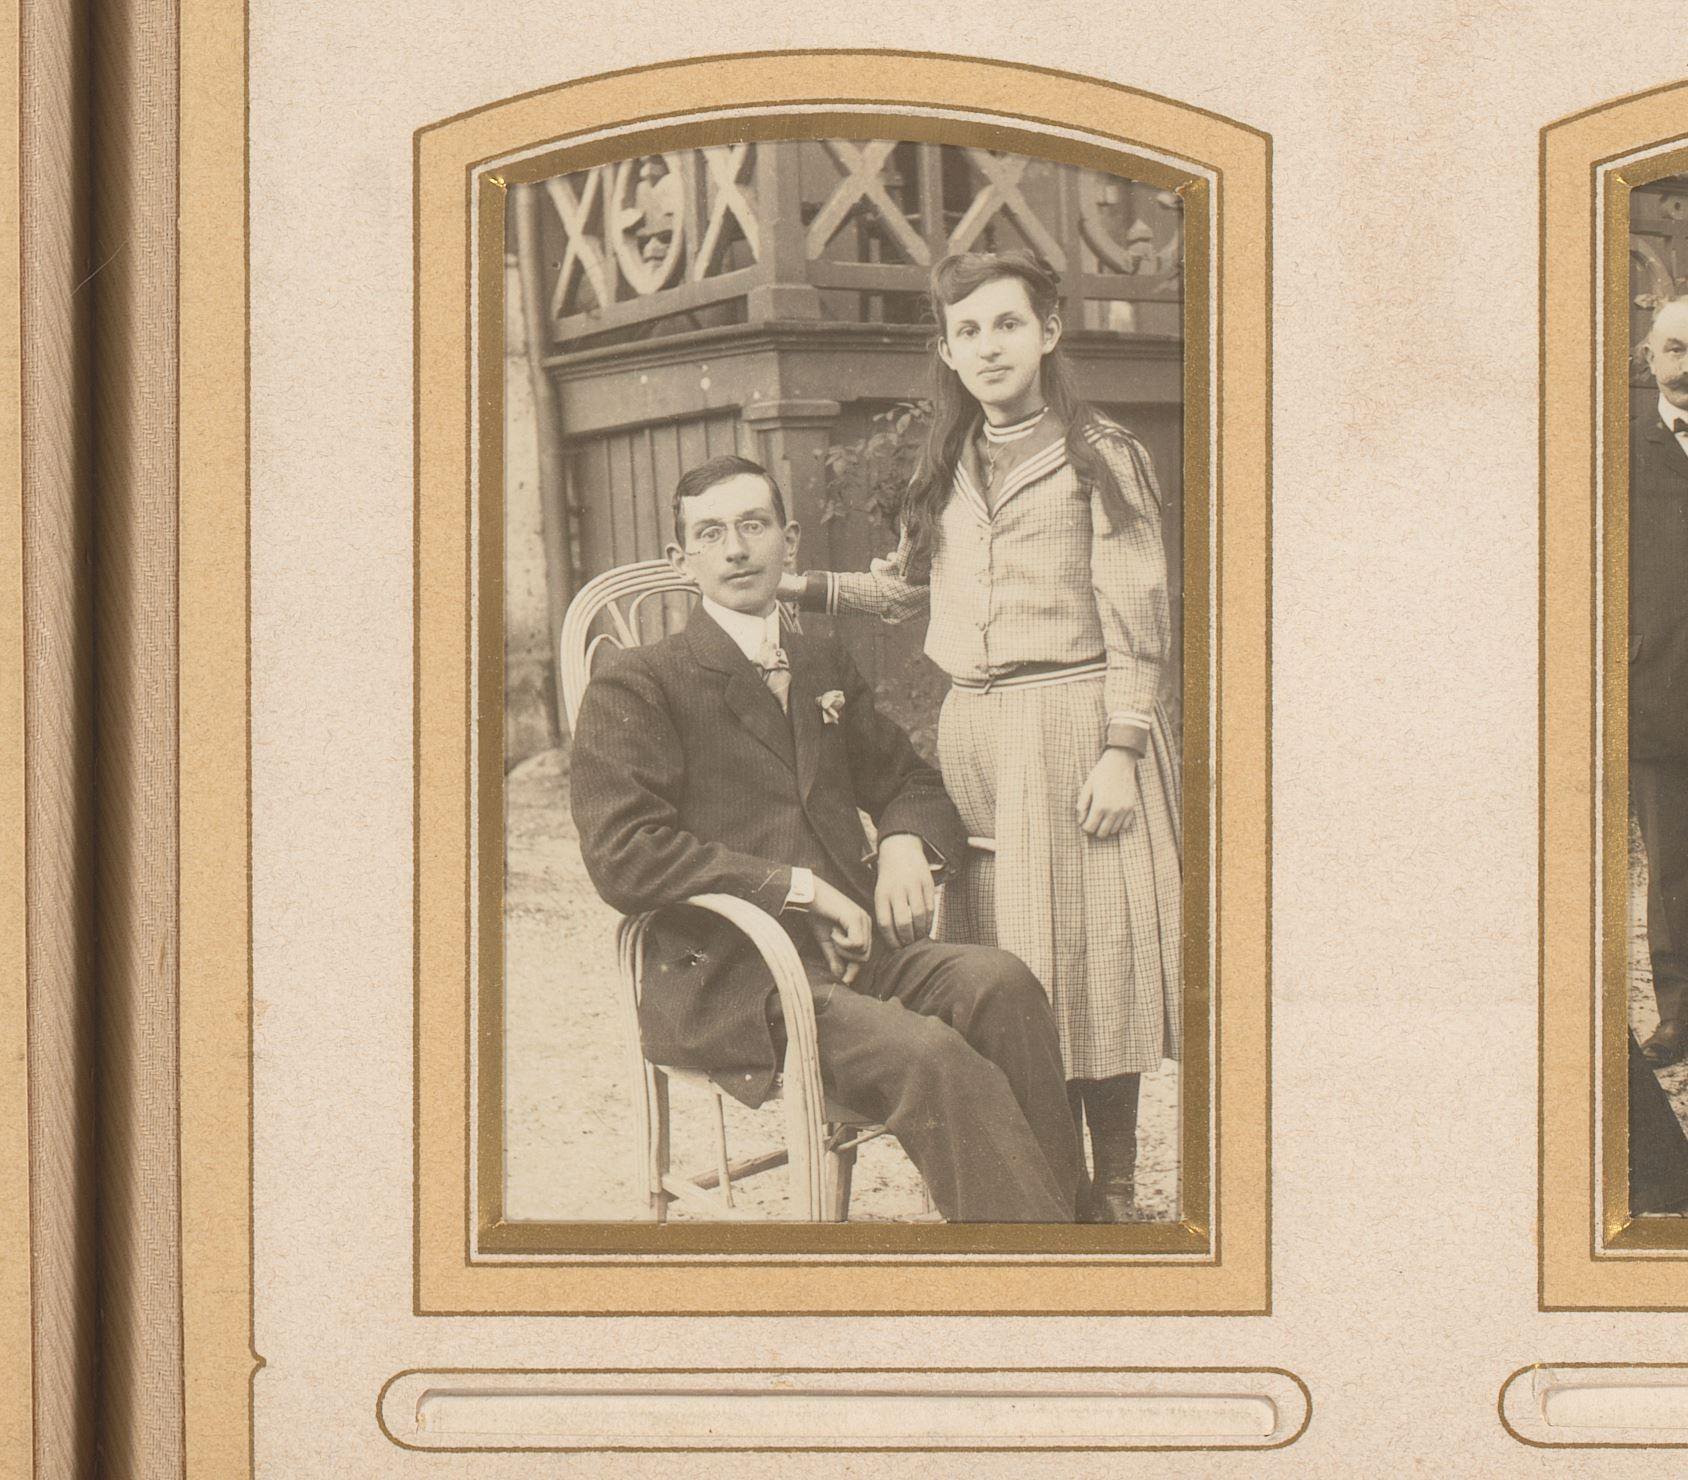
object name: photograph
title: Portret van een man en vrouw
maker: Anonymous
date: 1870-1900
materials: cardboard, photographic support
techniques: gelatin silver print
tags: adult woman, adult man, historical persons